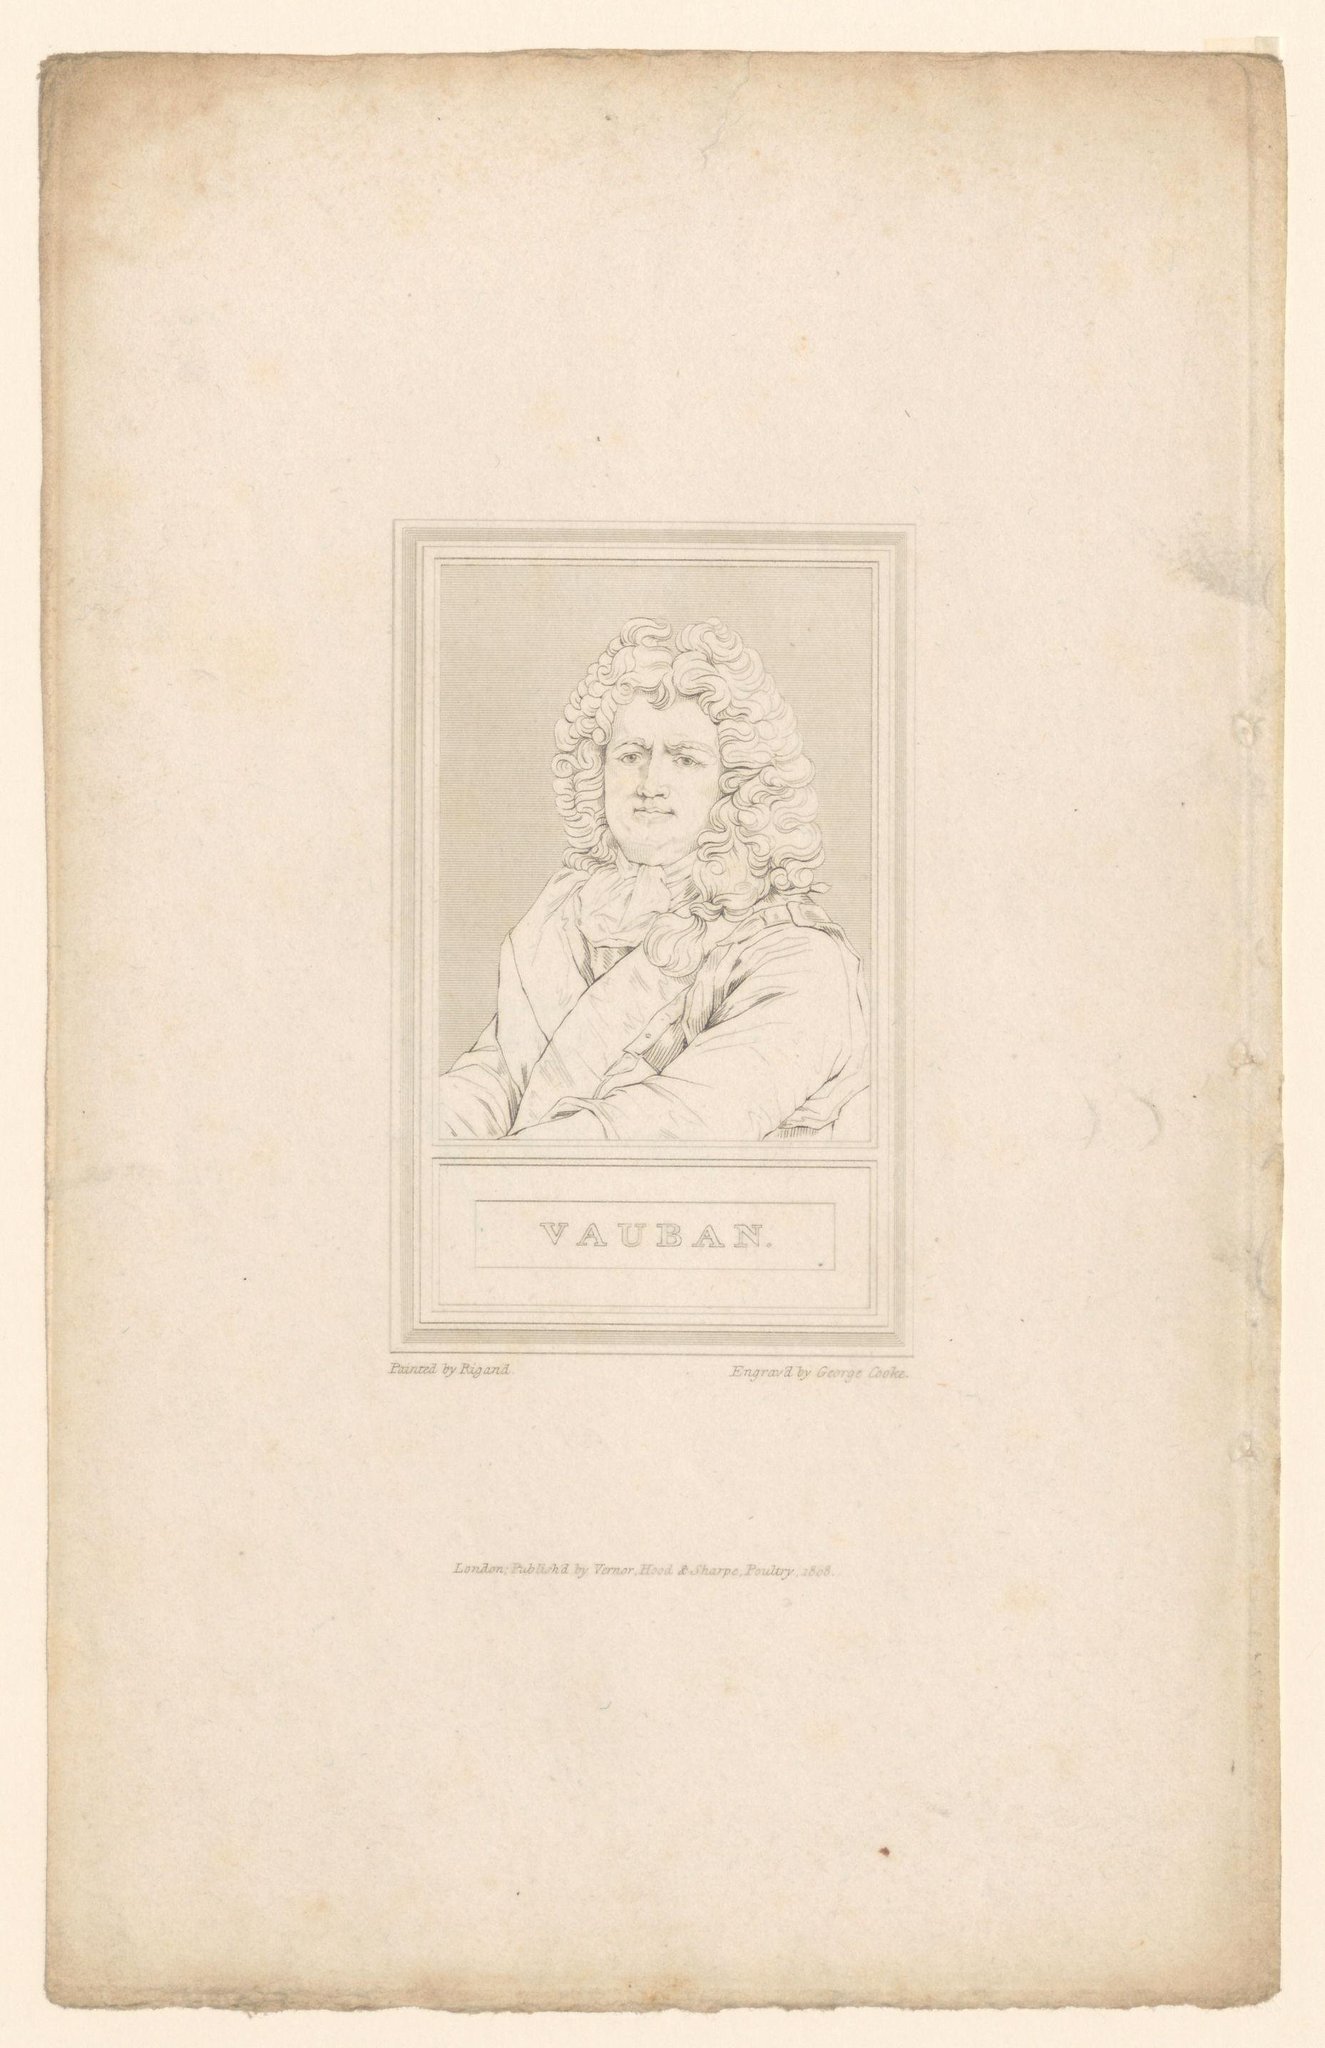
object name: book illustration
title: Portret van Sébastien le Prestre de Vauban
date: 1808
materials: paper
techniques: etching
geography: england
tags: engineer, sébastien le prestre de vauban, engineering (+ portrait of scholar, scientist), historical persons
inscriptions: collector's mark: Lugt 2228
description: Prent uit: The Historic Gallery of Portraits and Paintings (...). Londen: Vernor, Hood & Sharpe, 1808, dl. 3.